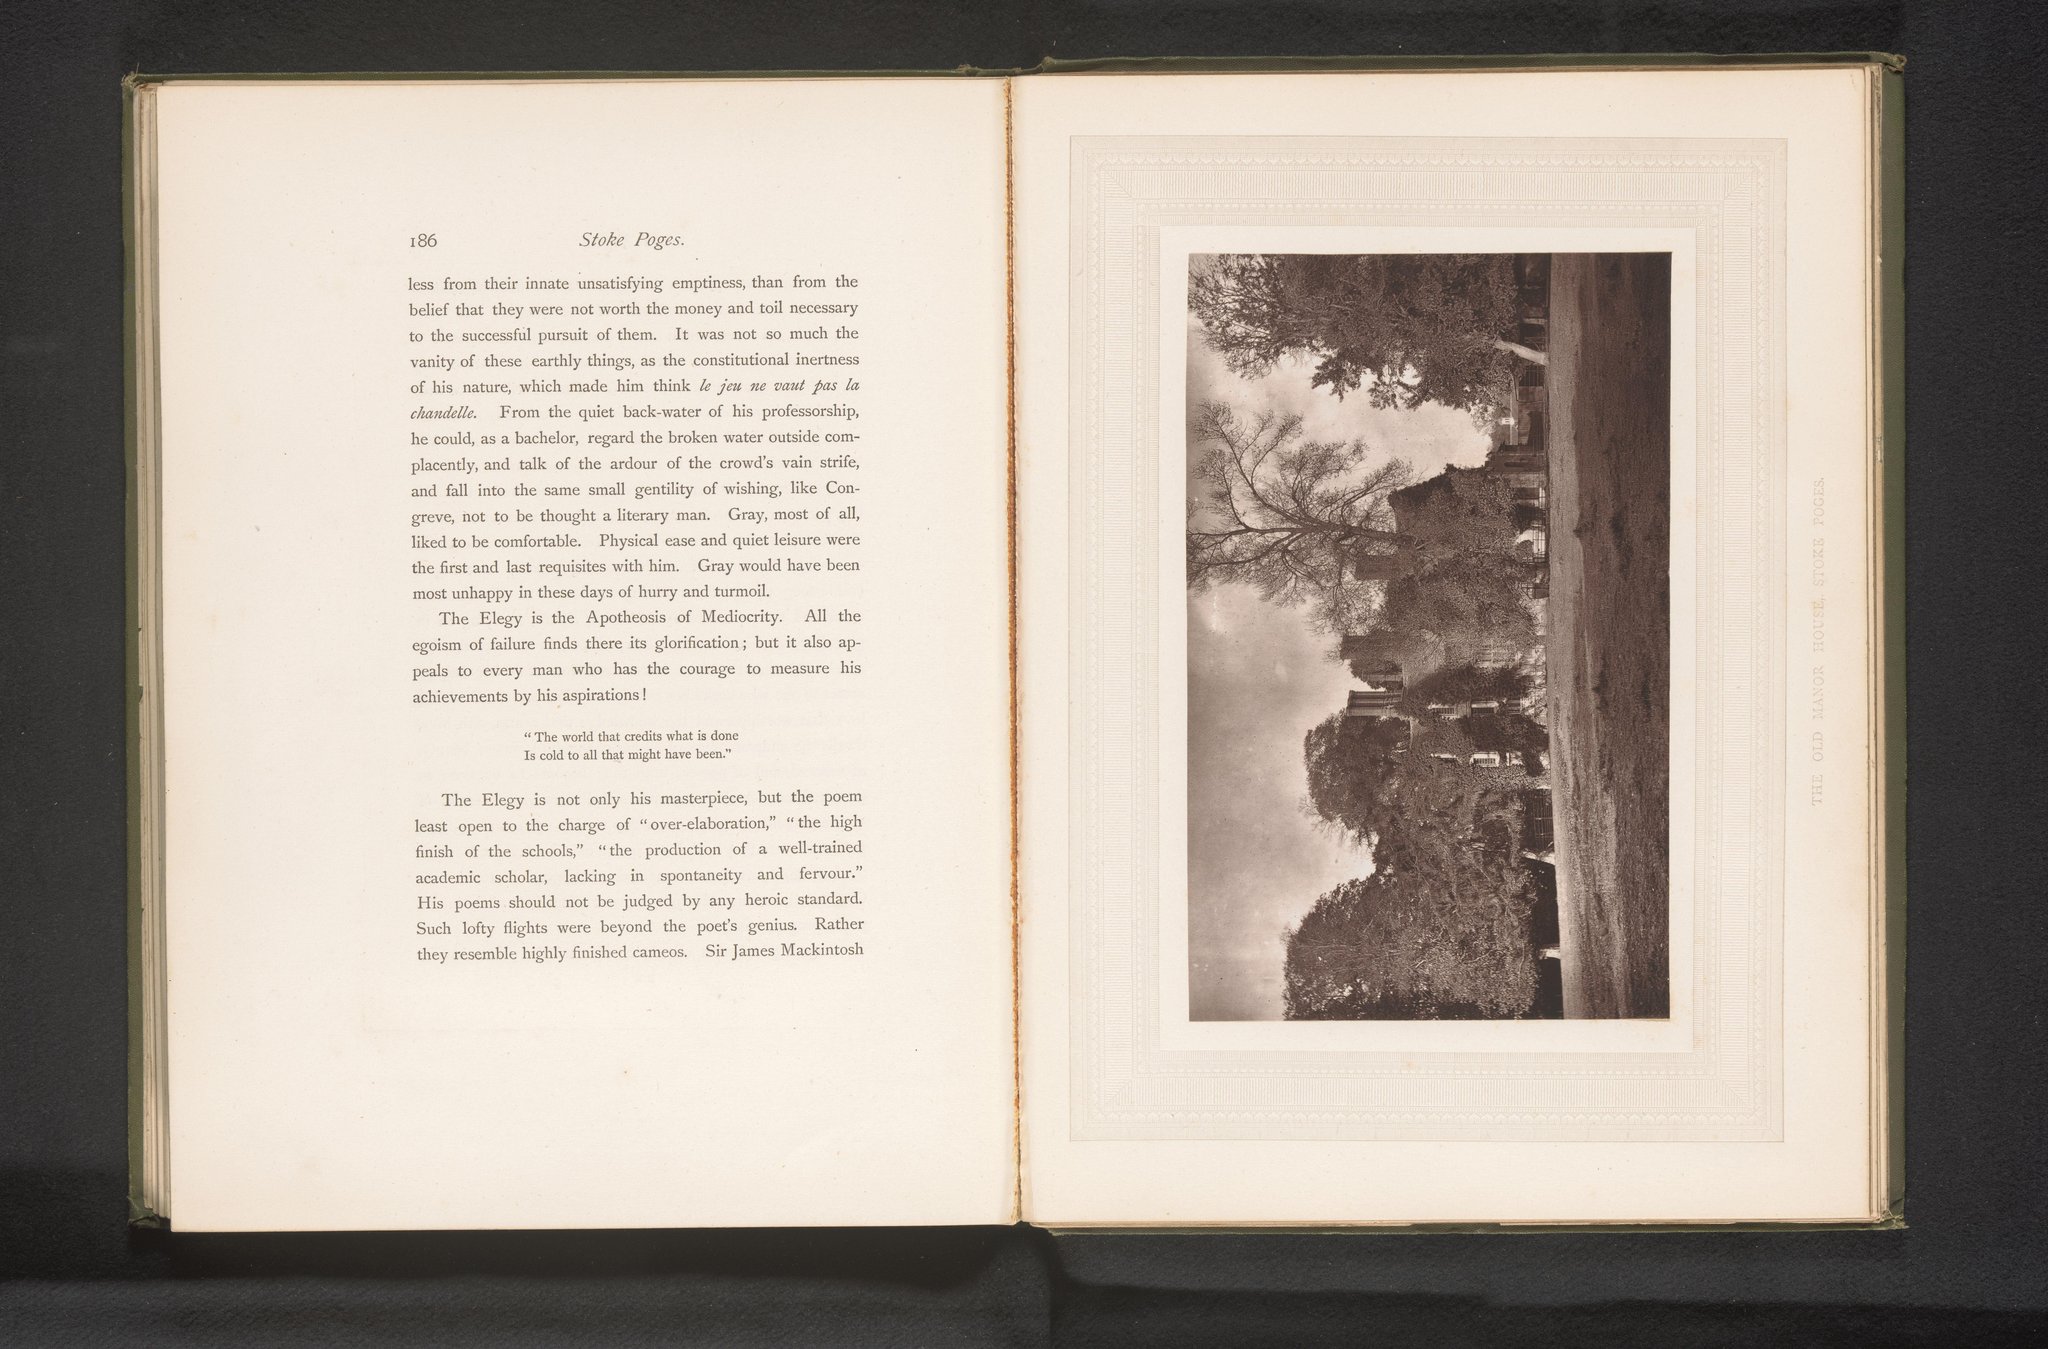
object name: photomechanical print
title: The old manor house, Stoke Poges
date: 1866-1876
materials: paper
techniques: woodburytype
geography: stoke poges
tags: country-house